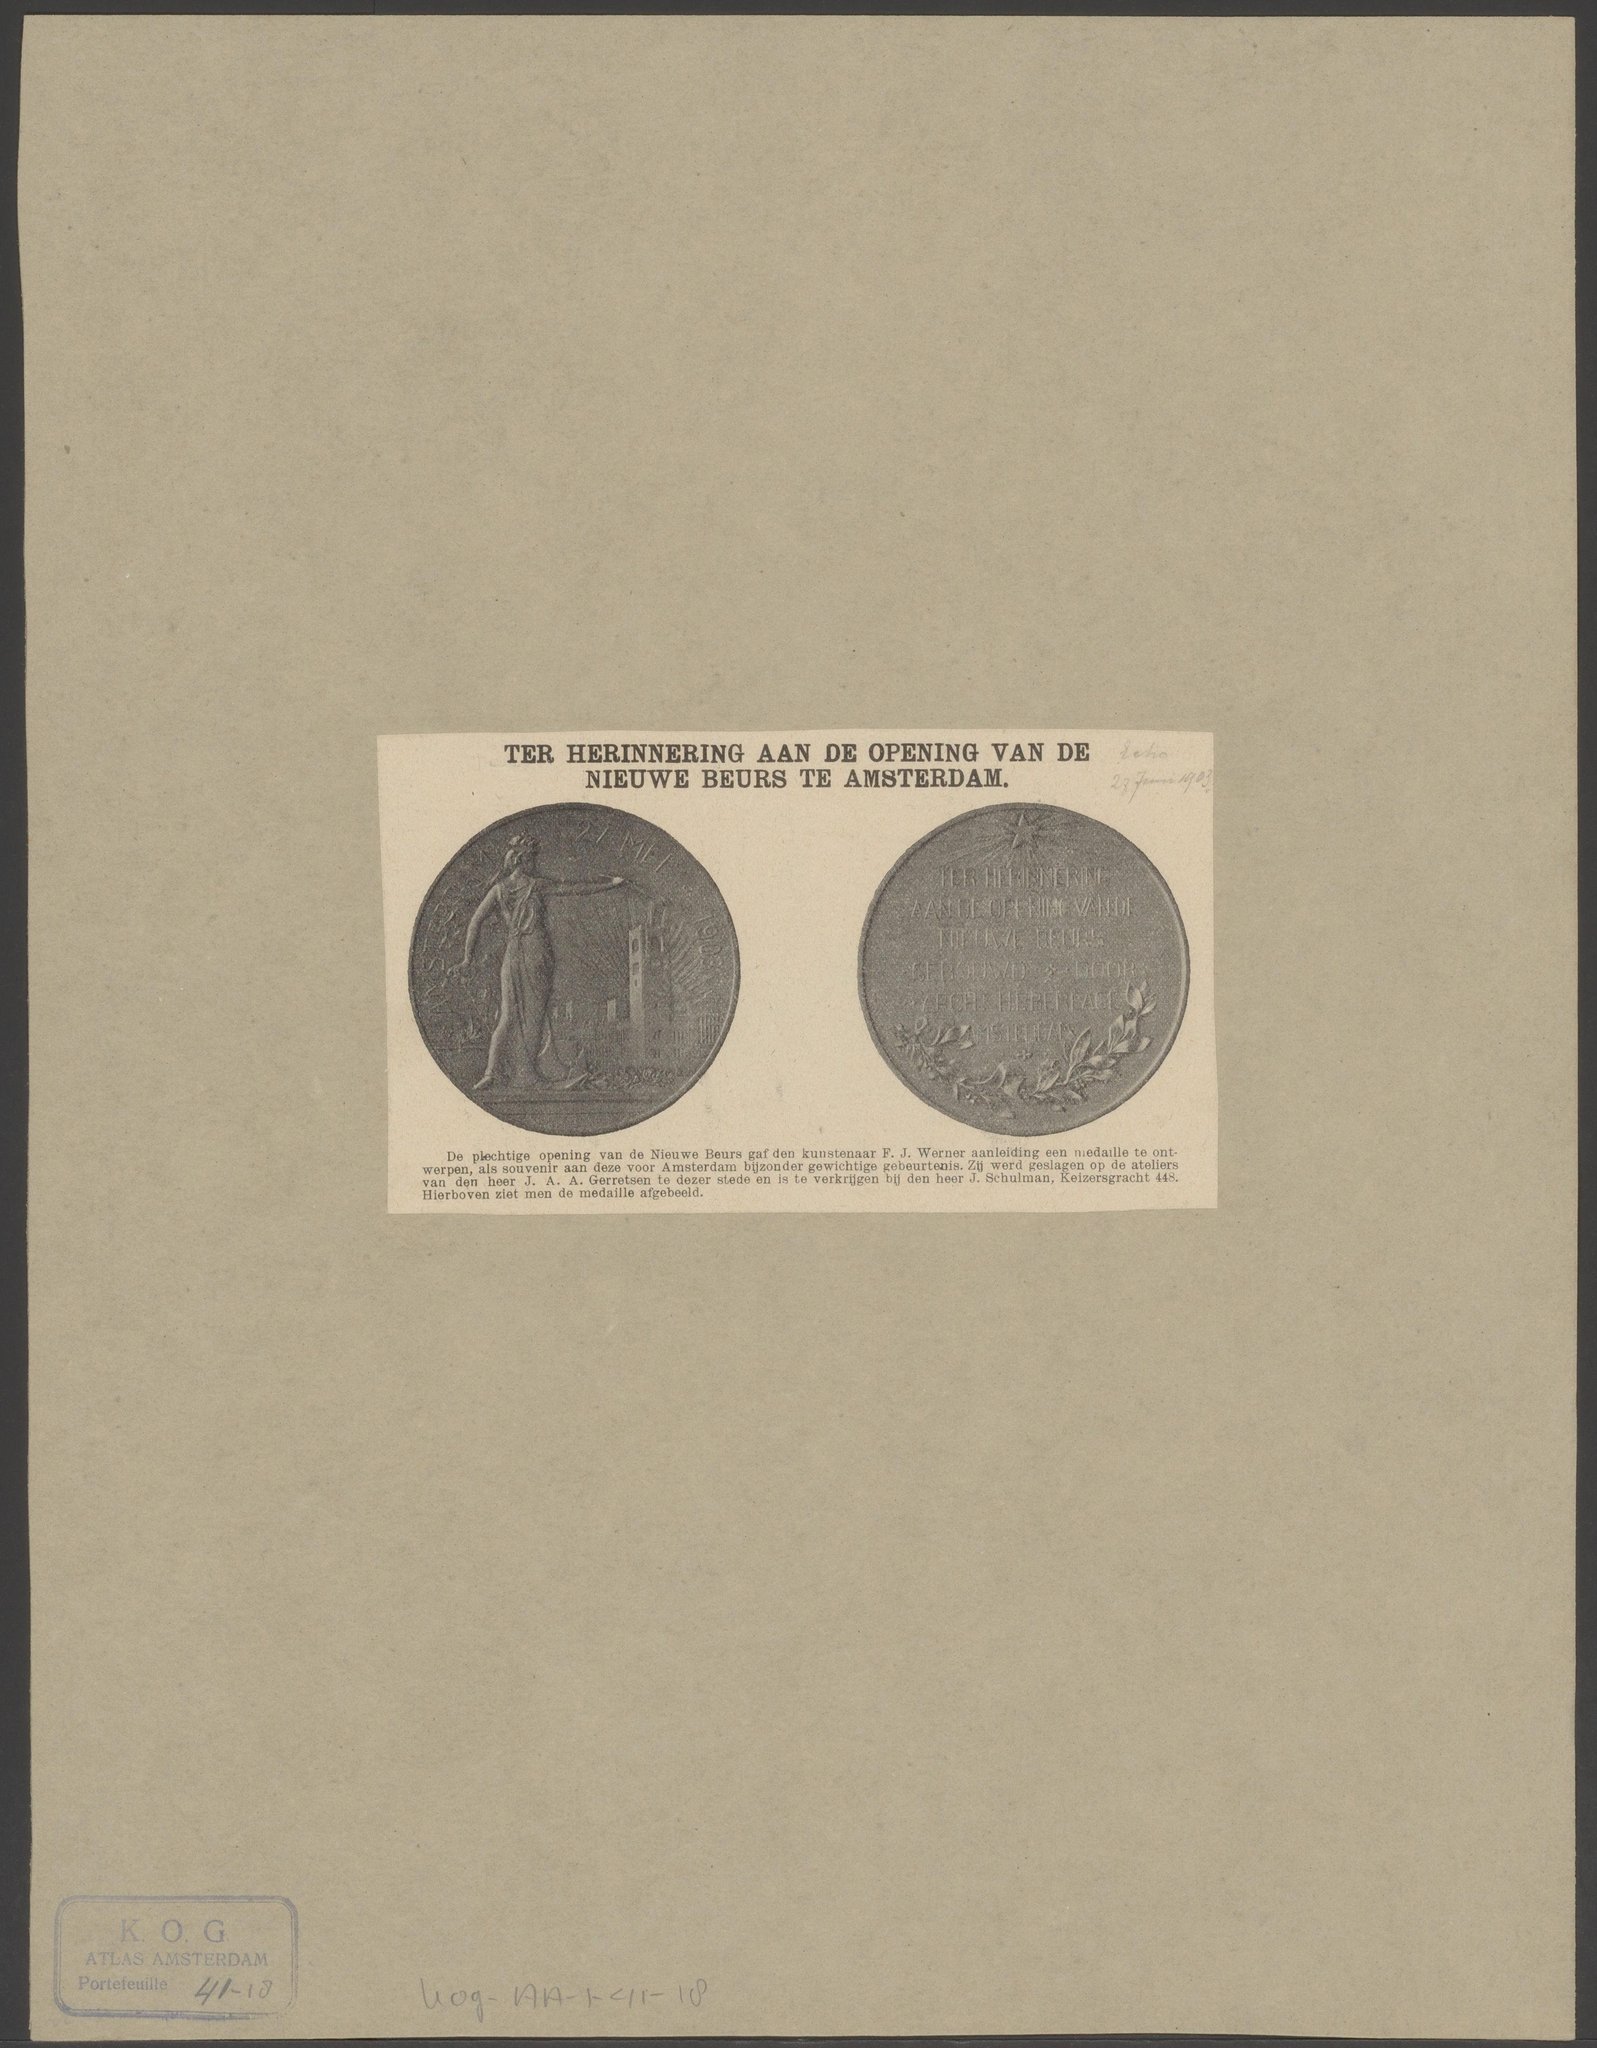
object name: photomechanical print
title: Medaille ter herinnering van de opening van de Beurs van Berlage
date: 1903-1906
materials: paper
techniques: autotype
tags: memorial medal, stock exchange, stock-market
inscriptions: collector's mark: Lugt 1461b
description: Penning ter herinnering van de opening van de Beurs van Berlage. Onderwerpsrubriek binnen de Atlas Amsterdam: B. Beurs op het Damrak.